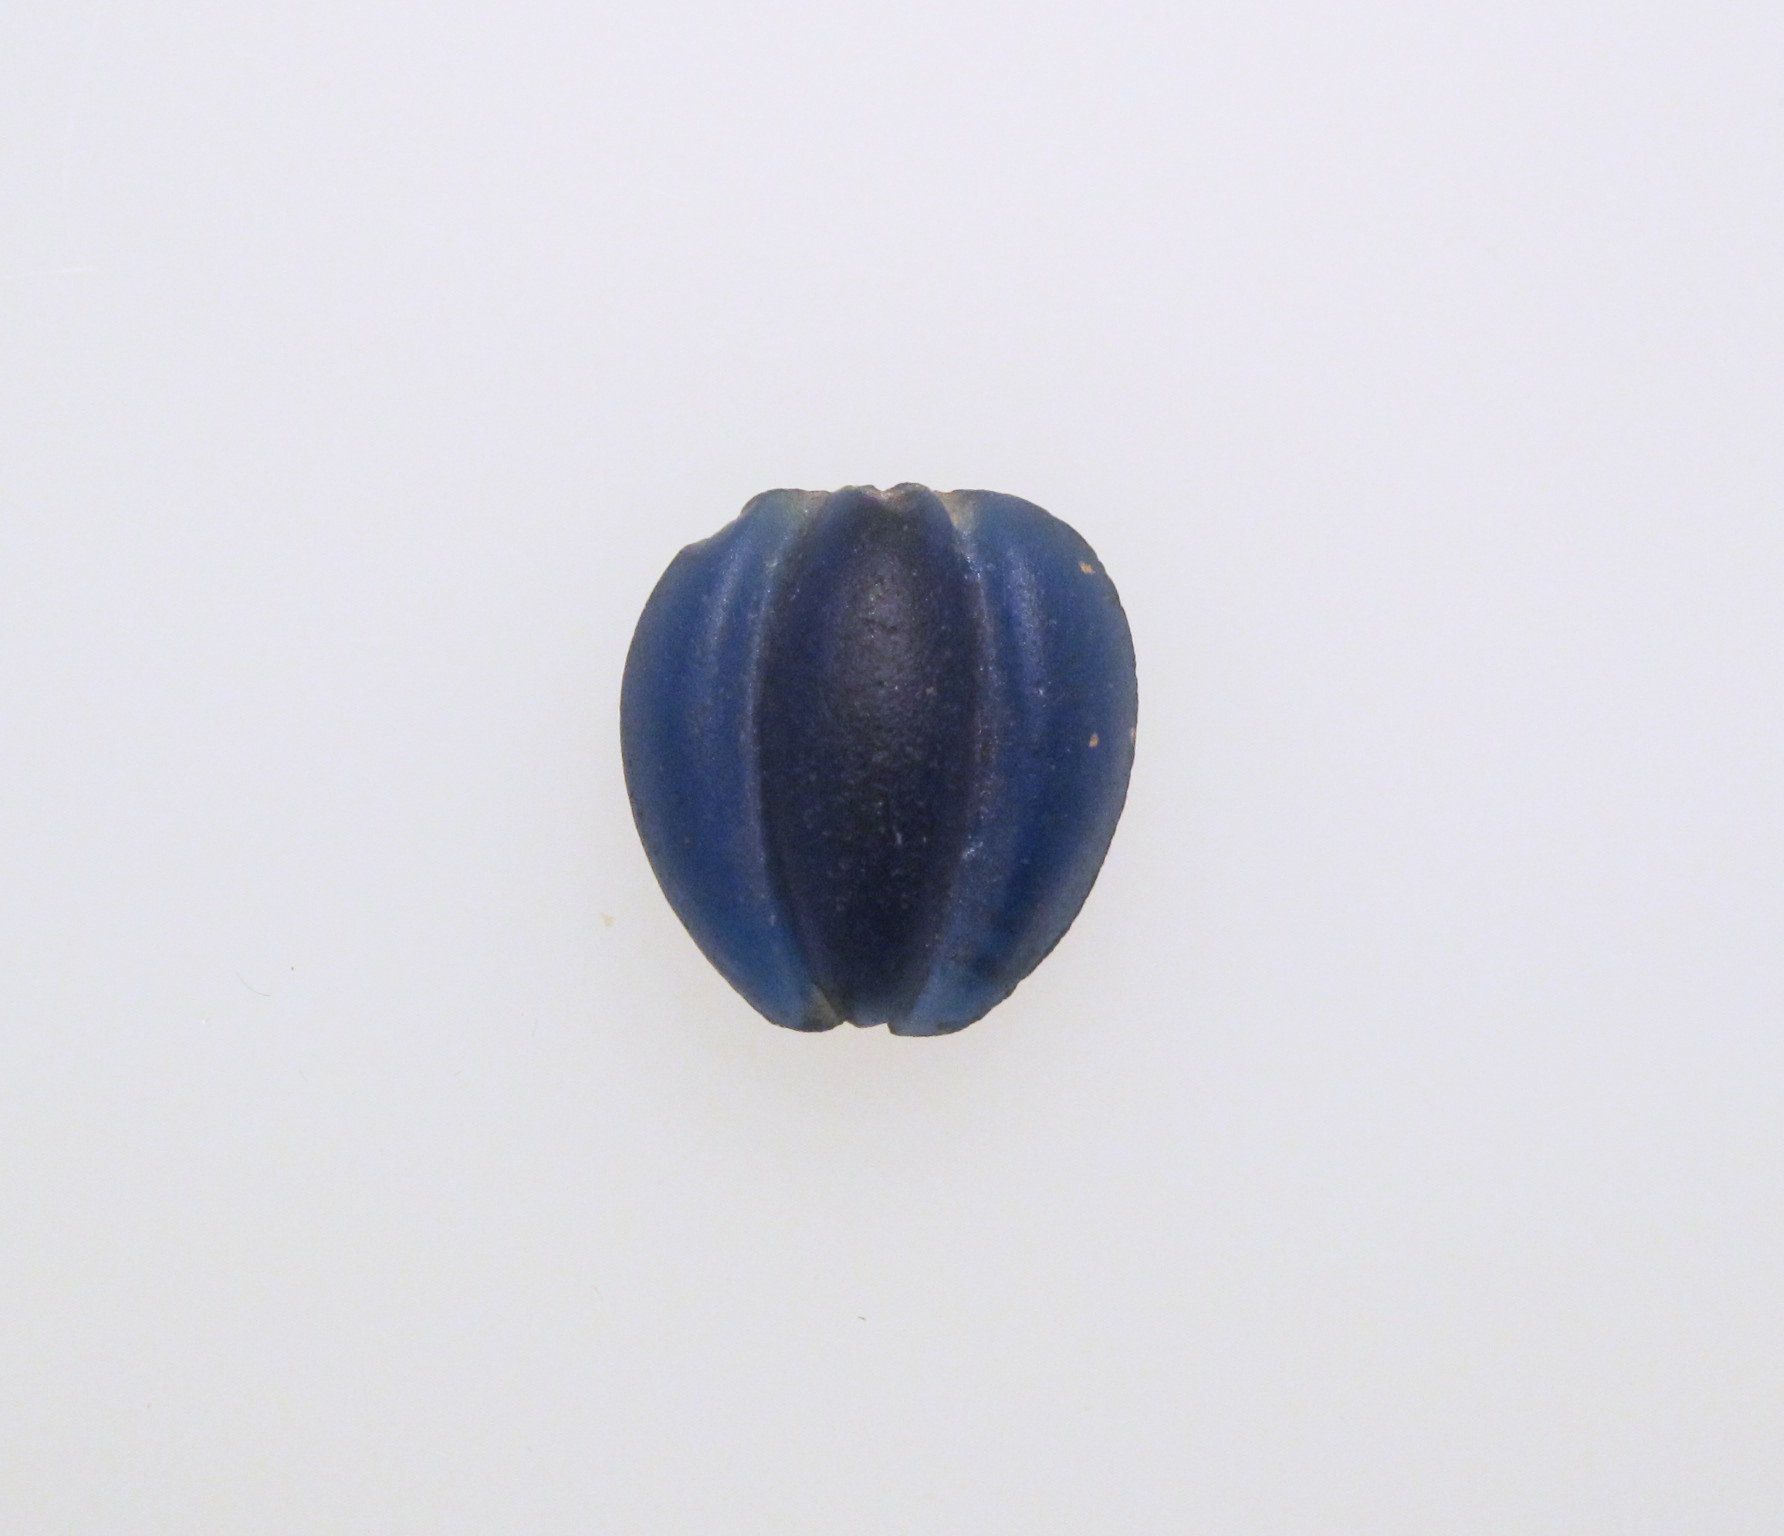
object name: bead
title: Glass spacer bead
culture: roman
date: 1-33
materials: glass